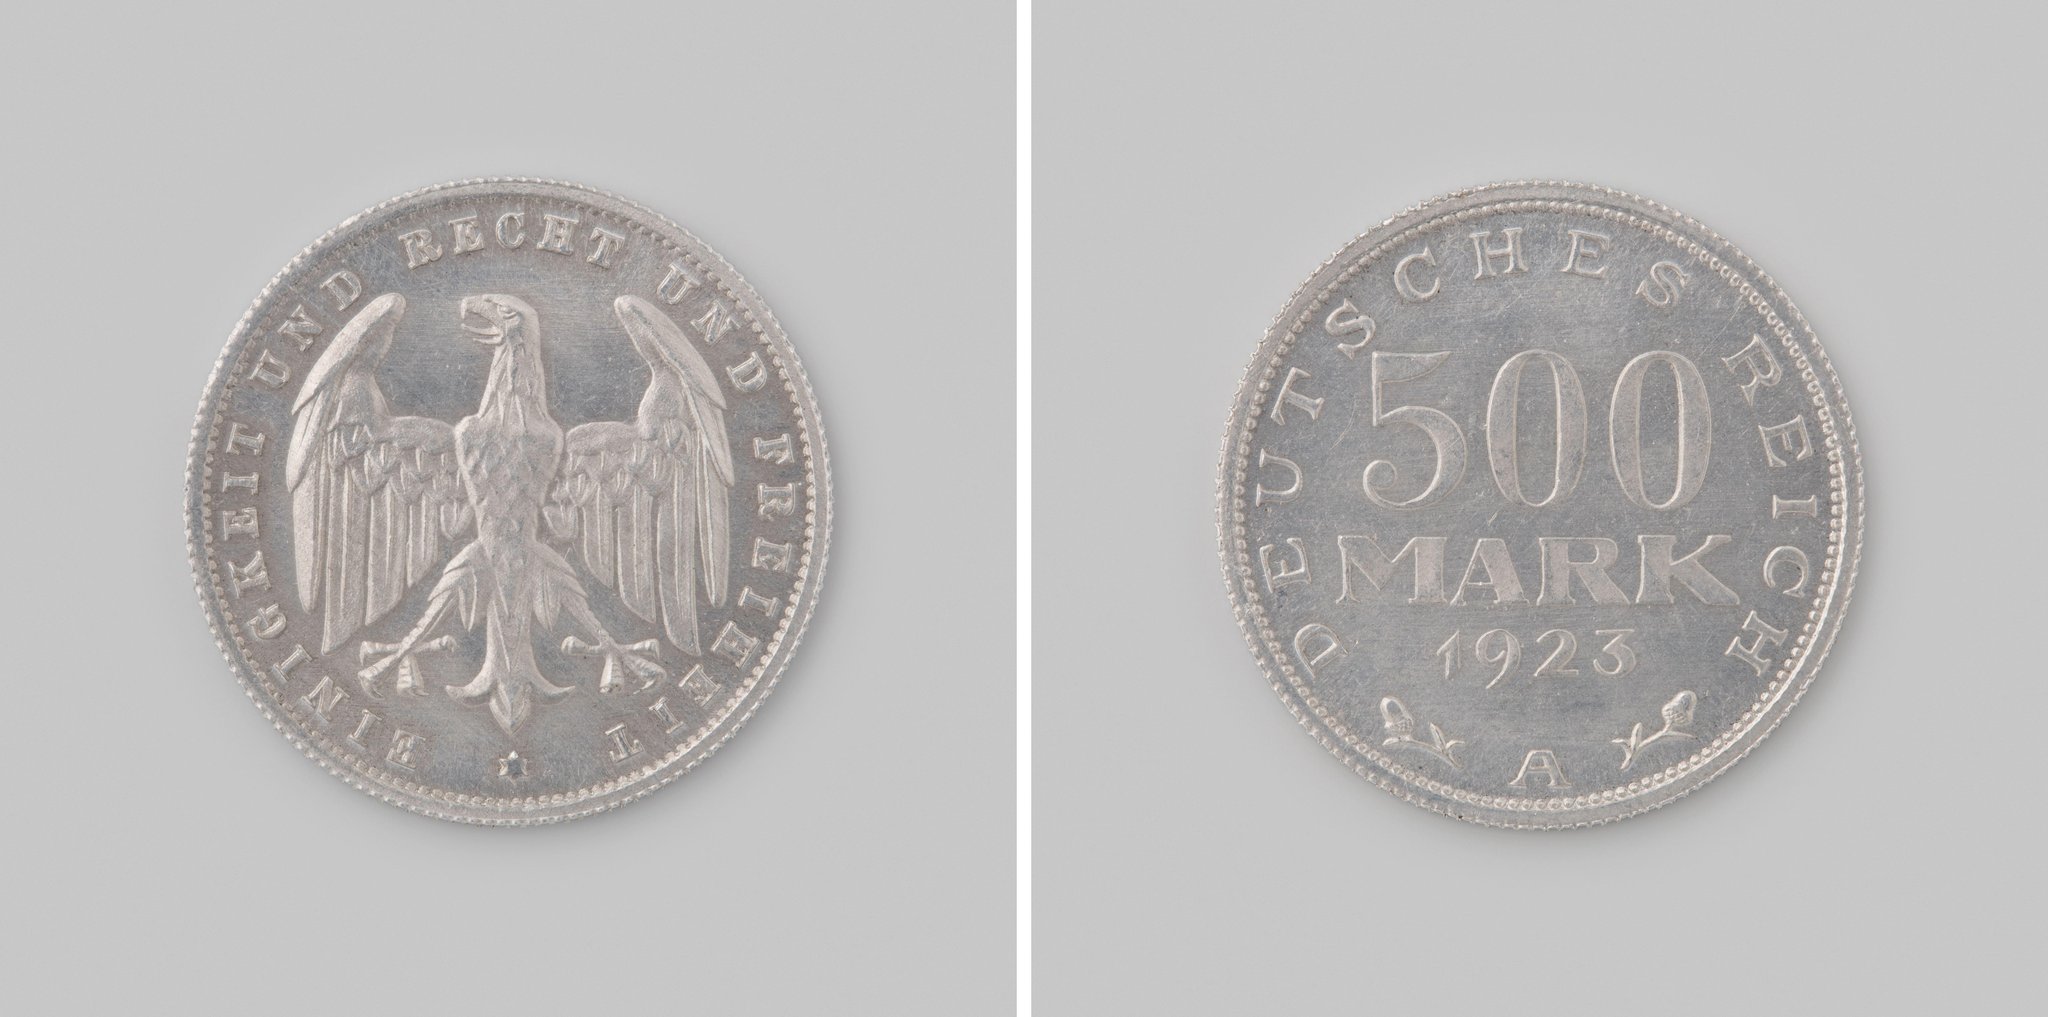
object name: coin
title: 500 Mark uit Duitsland, 1923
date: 1923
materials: aluminum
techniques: striking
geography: berlin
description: Aluminium munt. Voorzijde: enkelkoppige adelaar. Keerzijde: waarde-aanduiding in twee regels, waaronder jaartal. Daaronder letter A. Kartelrand.